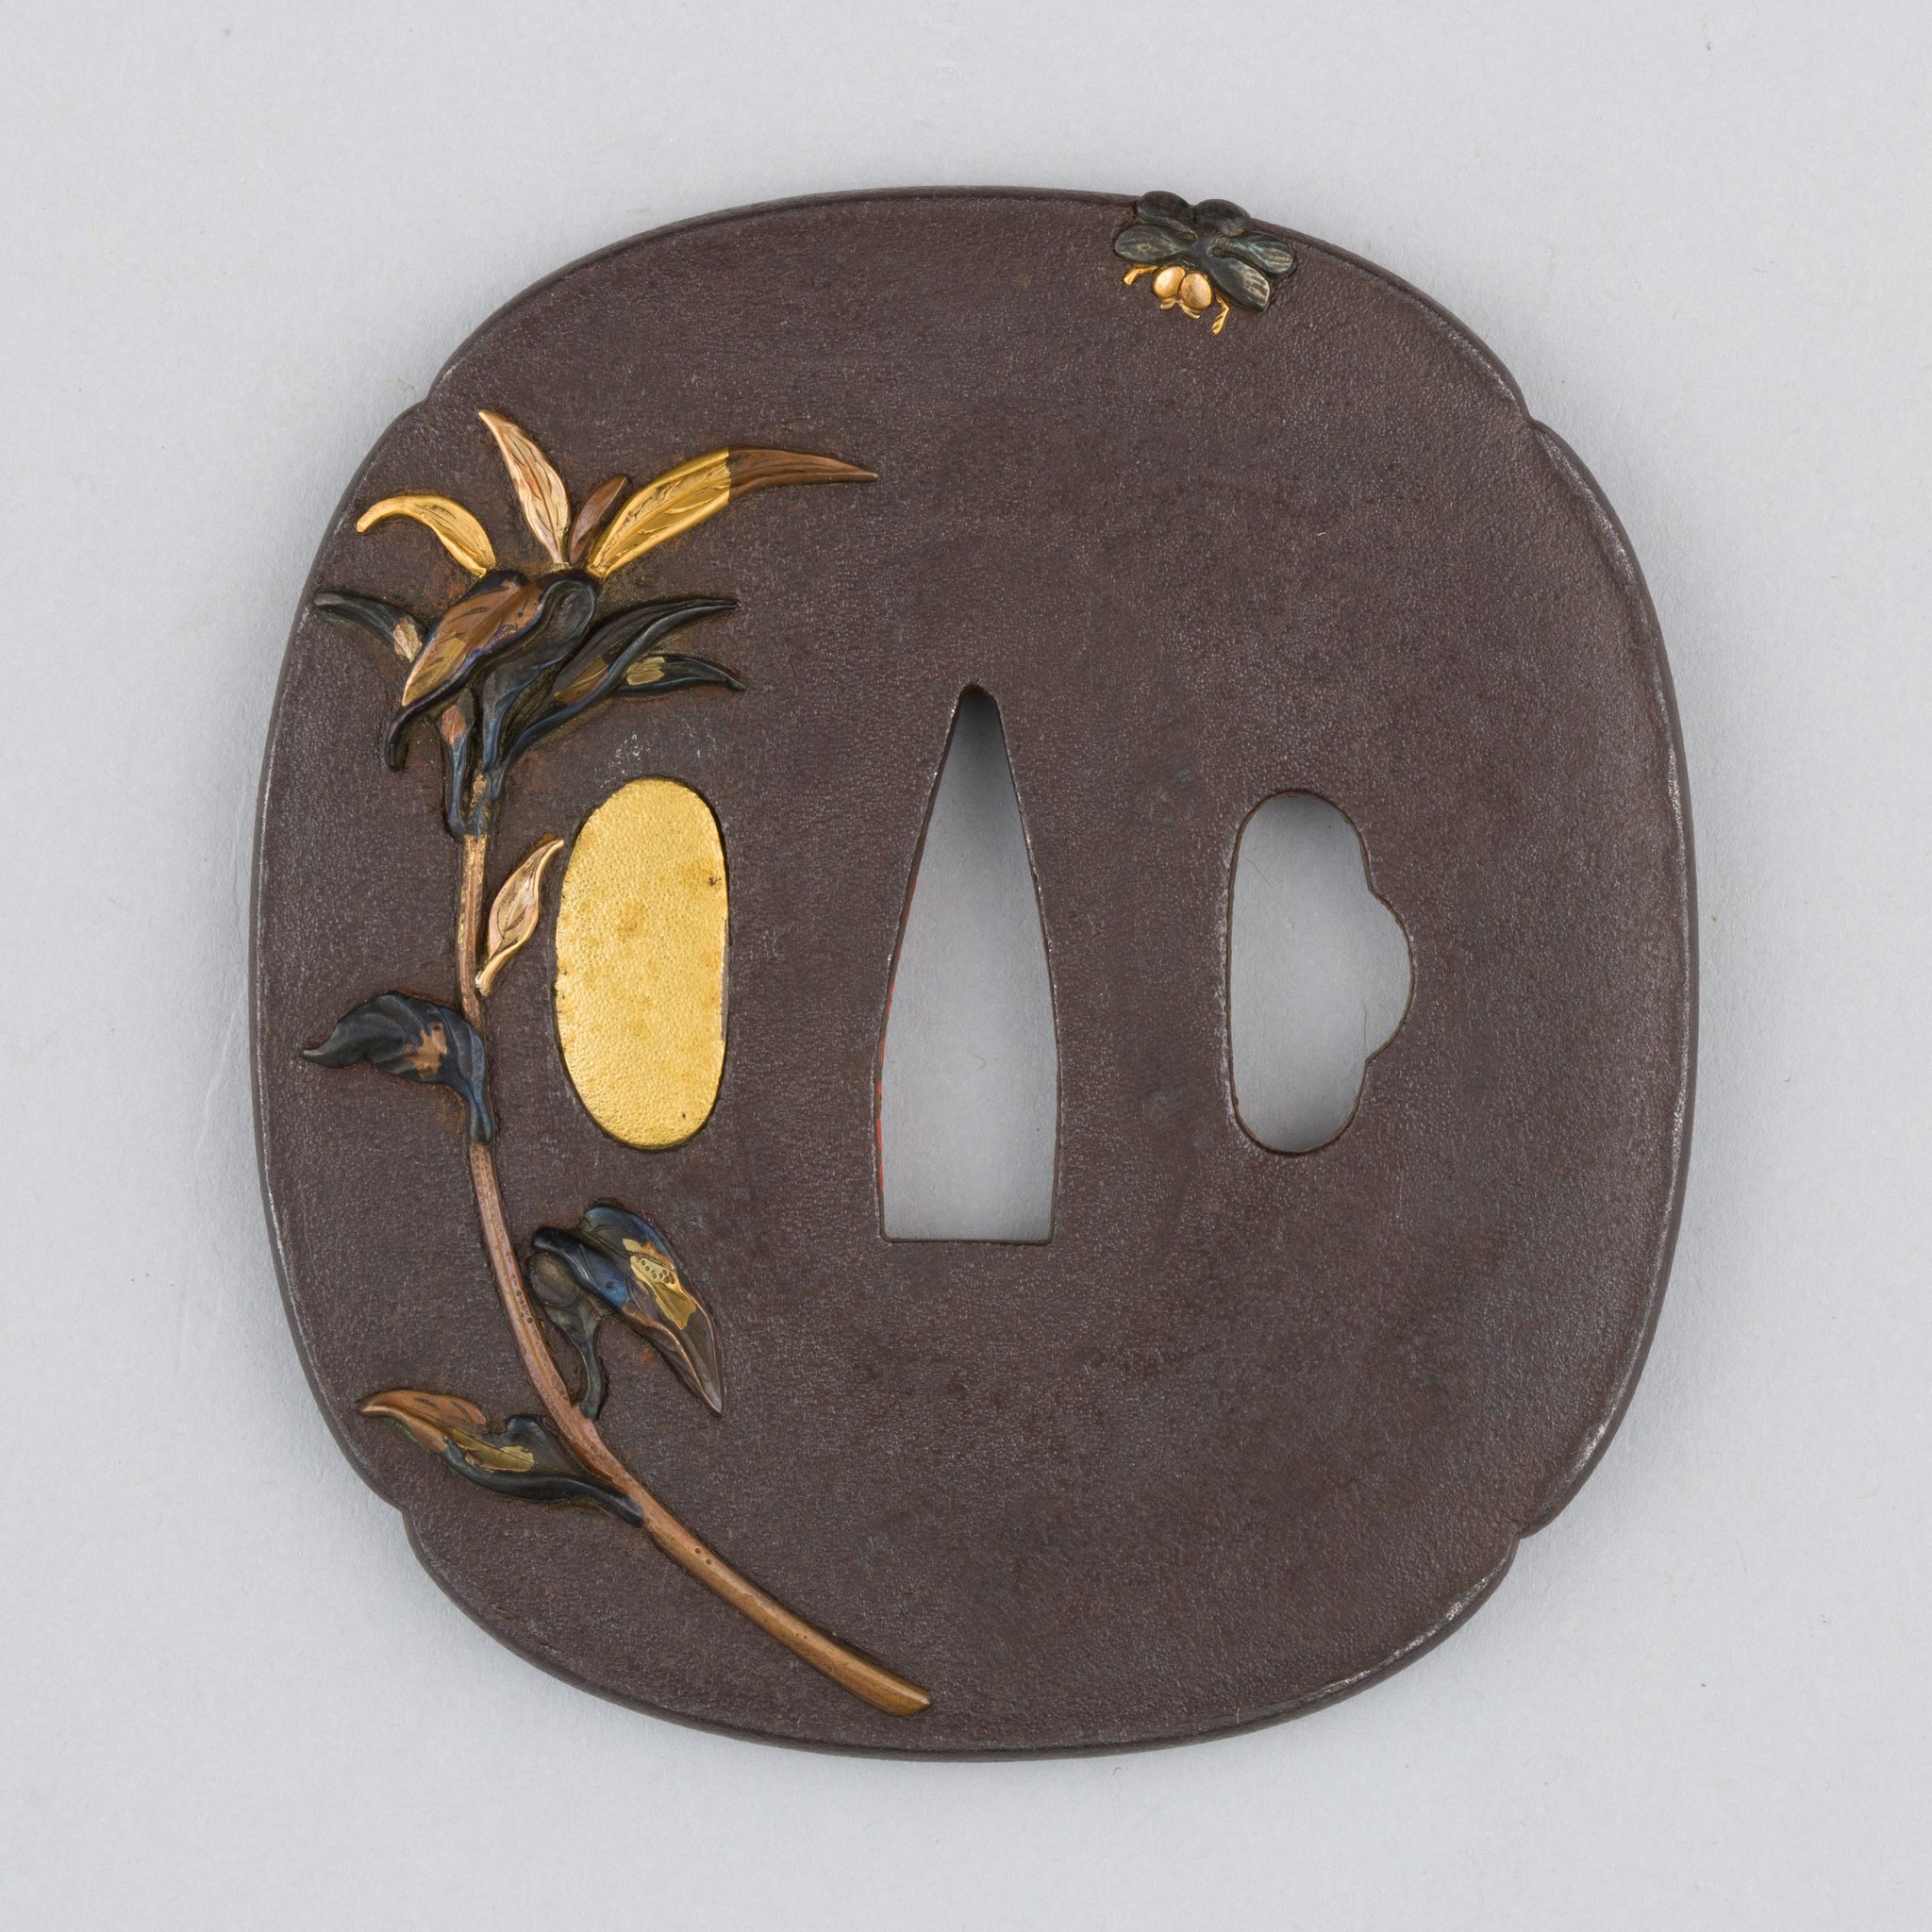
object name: sword guard tsuba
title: Sword Guard (Tsuba)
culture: japanese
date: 1701-1800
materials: copper, gold alloy, silver alloy, gold, iron, silver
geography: japan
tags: insects,plants